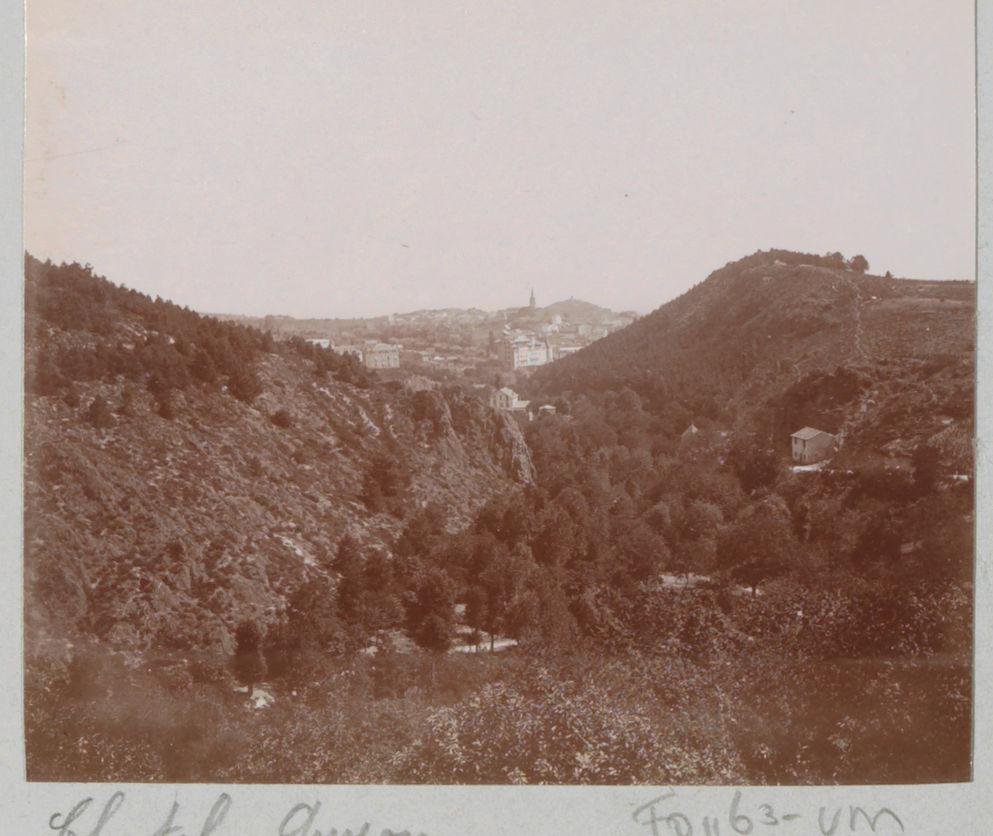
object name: photograph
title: Gezicht op Châtel-Guyon over beboste berghellingen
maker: delizy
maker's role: manufacturer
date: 1904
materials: paper, photographic support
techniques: gelatin silver print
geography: châtel-guyon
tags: prospect of village, silhouette of village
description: Onderdeel van Fotoalbum van een Franse amateurfotograaf met opnames van uitstapjes in Frankrijk, Spanje, België, Luxemburg en Nederland, de eerste automobielen en autoraces.